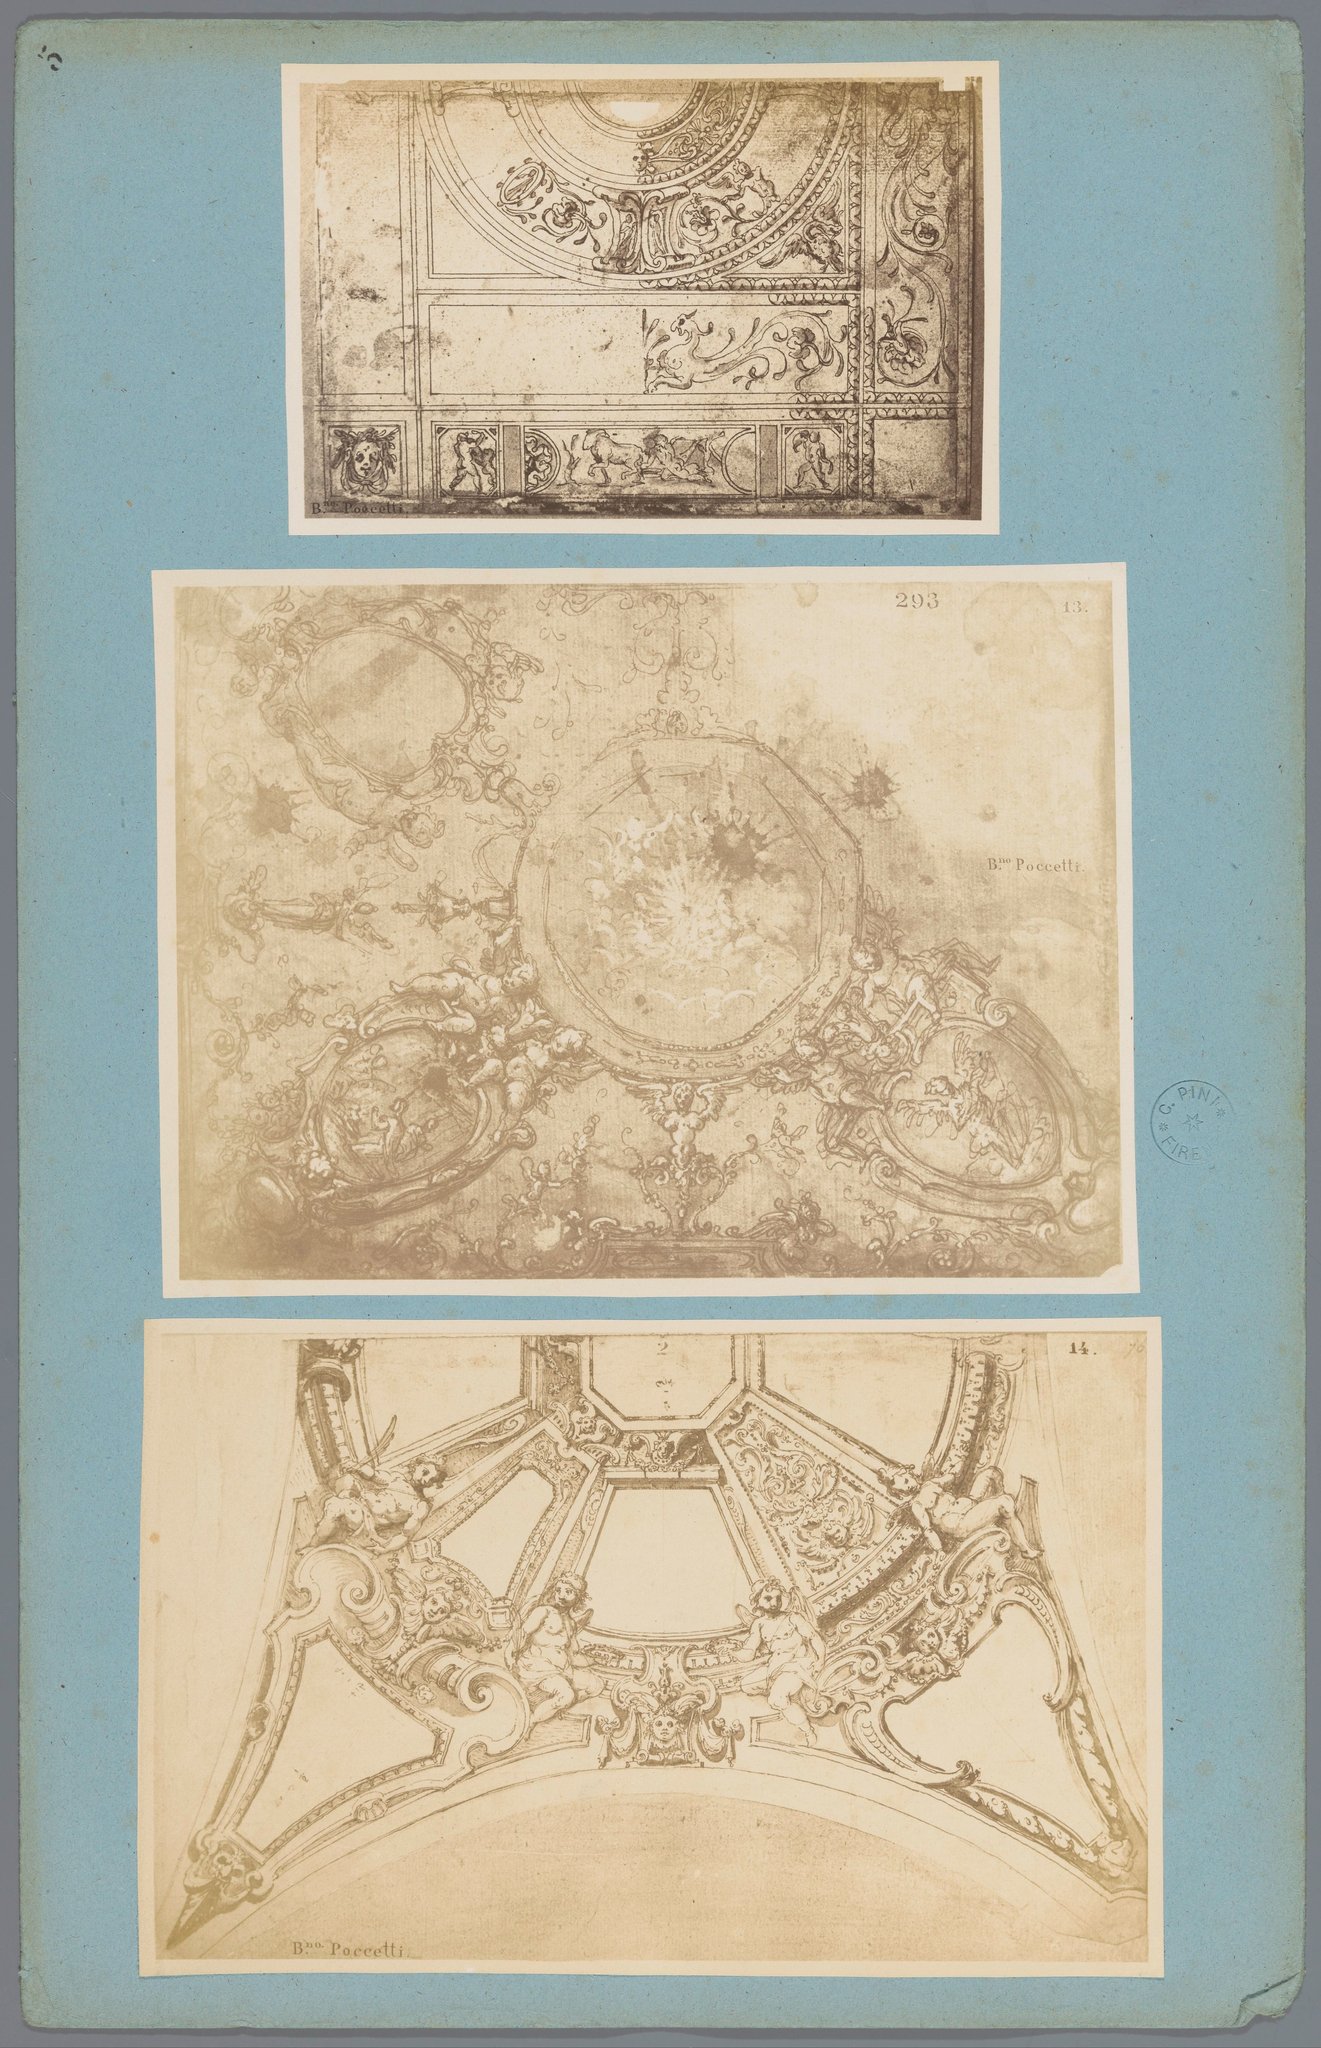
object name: photograph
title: Drie fotoreproducties van wand en plafonddecoraties door Bernardino Poccetti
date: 1875-1900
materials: cardboard, photographic support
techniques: albumen print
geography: europe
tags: drawing, sketch, ornament ~ cartouche, cupids: 'amores', 'amoretti', 'putti', ornament derived from plant forms, europe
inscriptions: number: ‘5’, name: ‘C. Pini Firenze’, collector's mark: Lugt 3937, number: ‘13.’, number: ‘14.’, number: ‘293’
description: Boven een vlakverdeling geornamenteerd met plantmotieven en dieren, midden (13) een plafond met engelen en cartouches, onder (14) een casetteplafond met engelen.